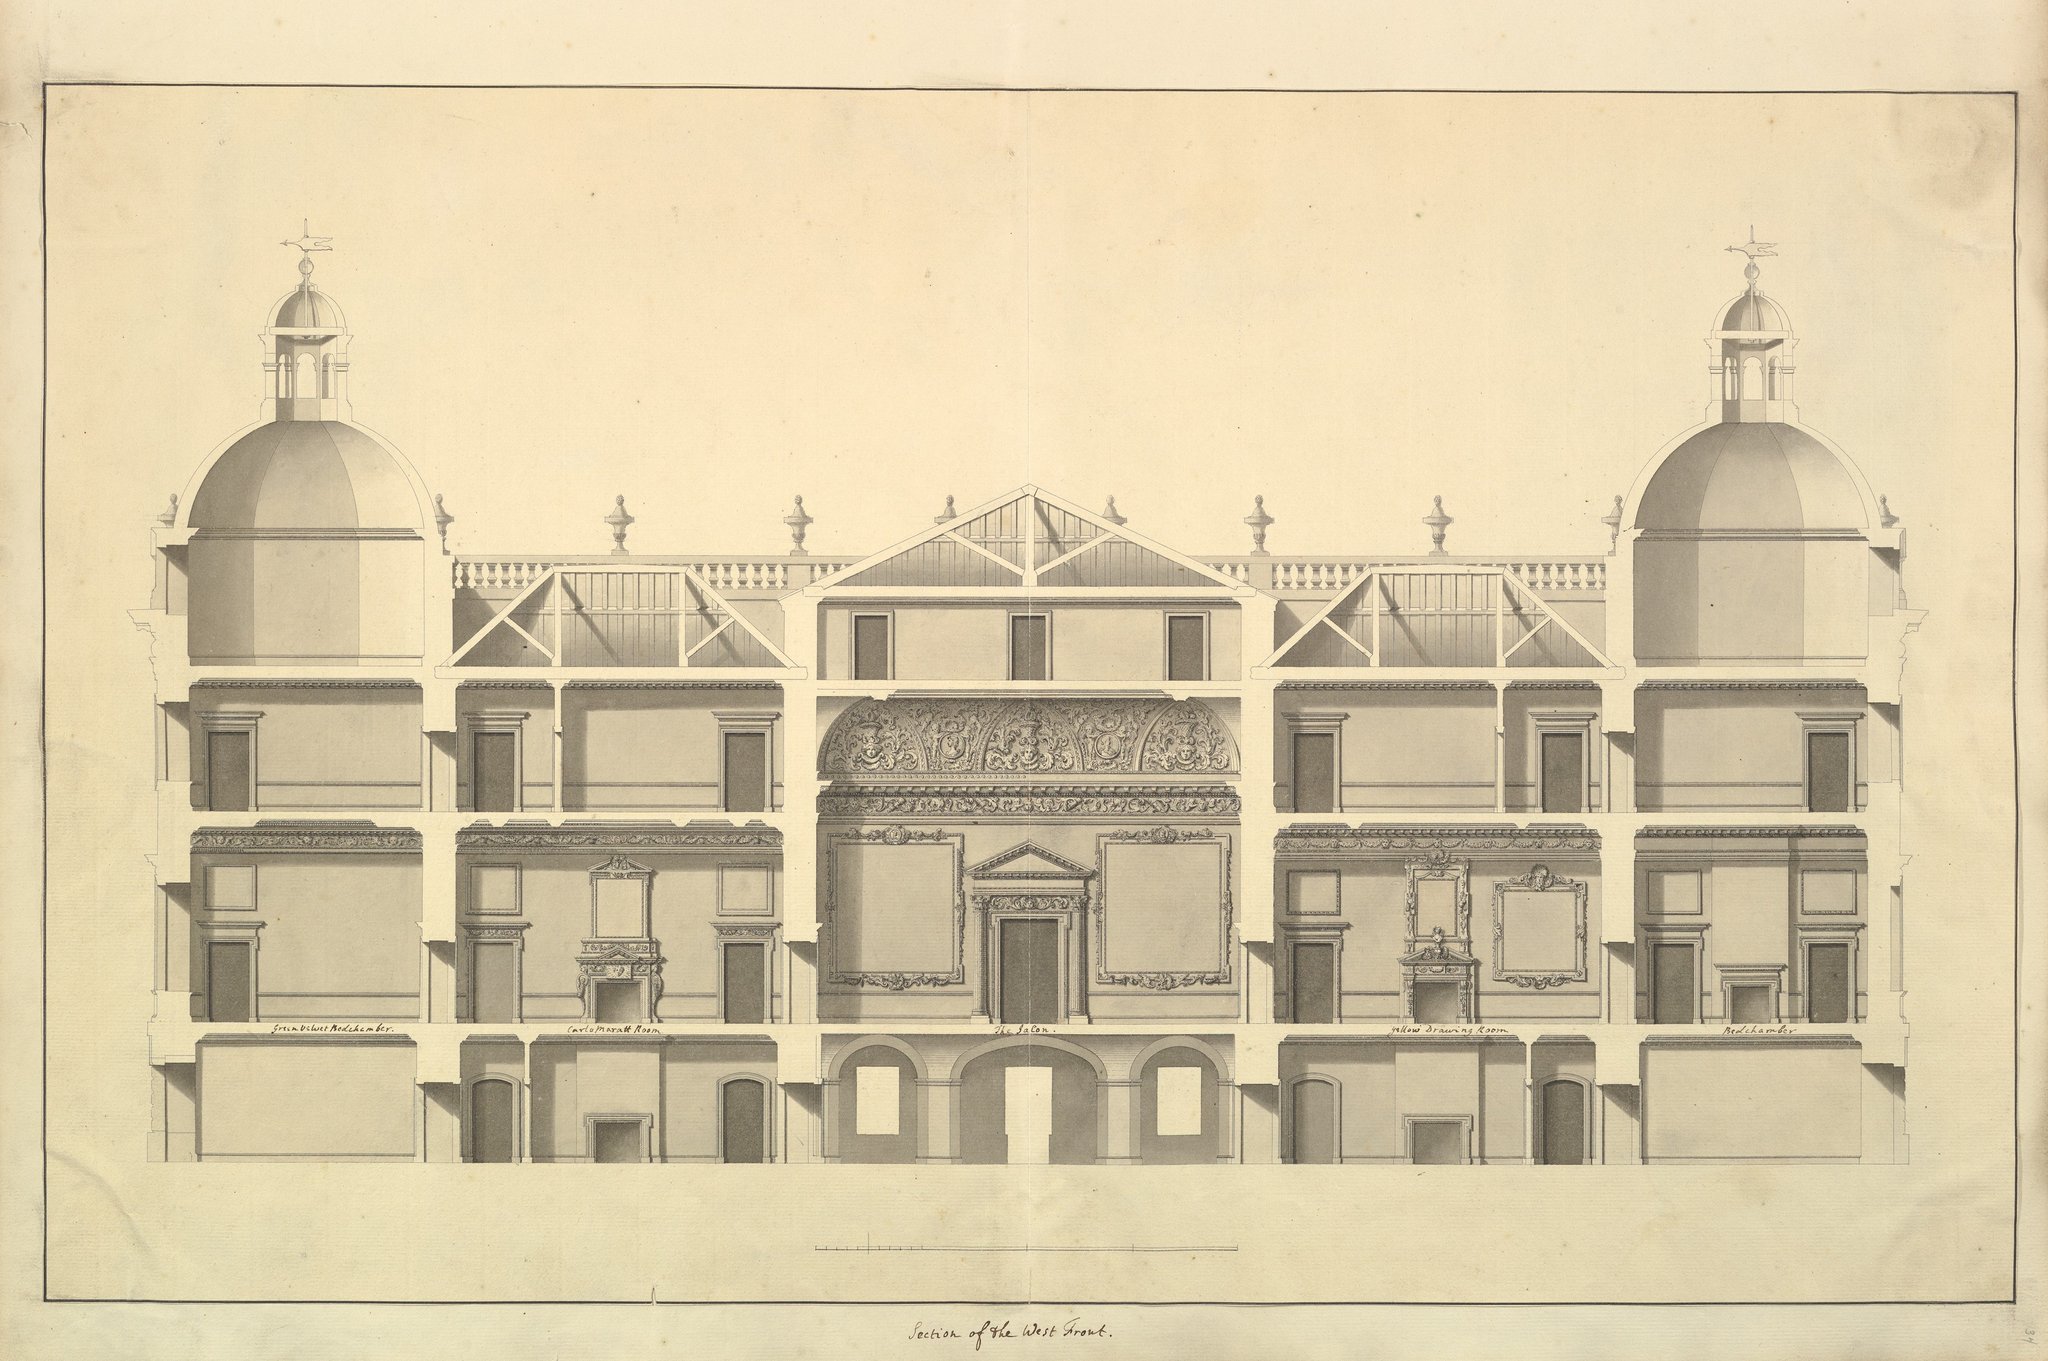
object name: drawing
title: Section of the West Front, Houghton Hall, Norfolk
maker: isaac ware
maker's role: artist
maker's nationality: british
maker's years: 1704-1766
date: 1735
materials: ink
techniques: brush, pen, wash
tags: architecture,buildings,houses